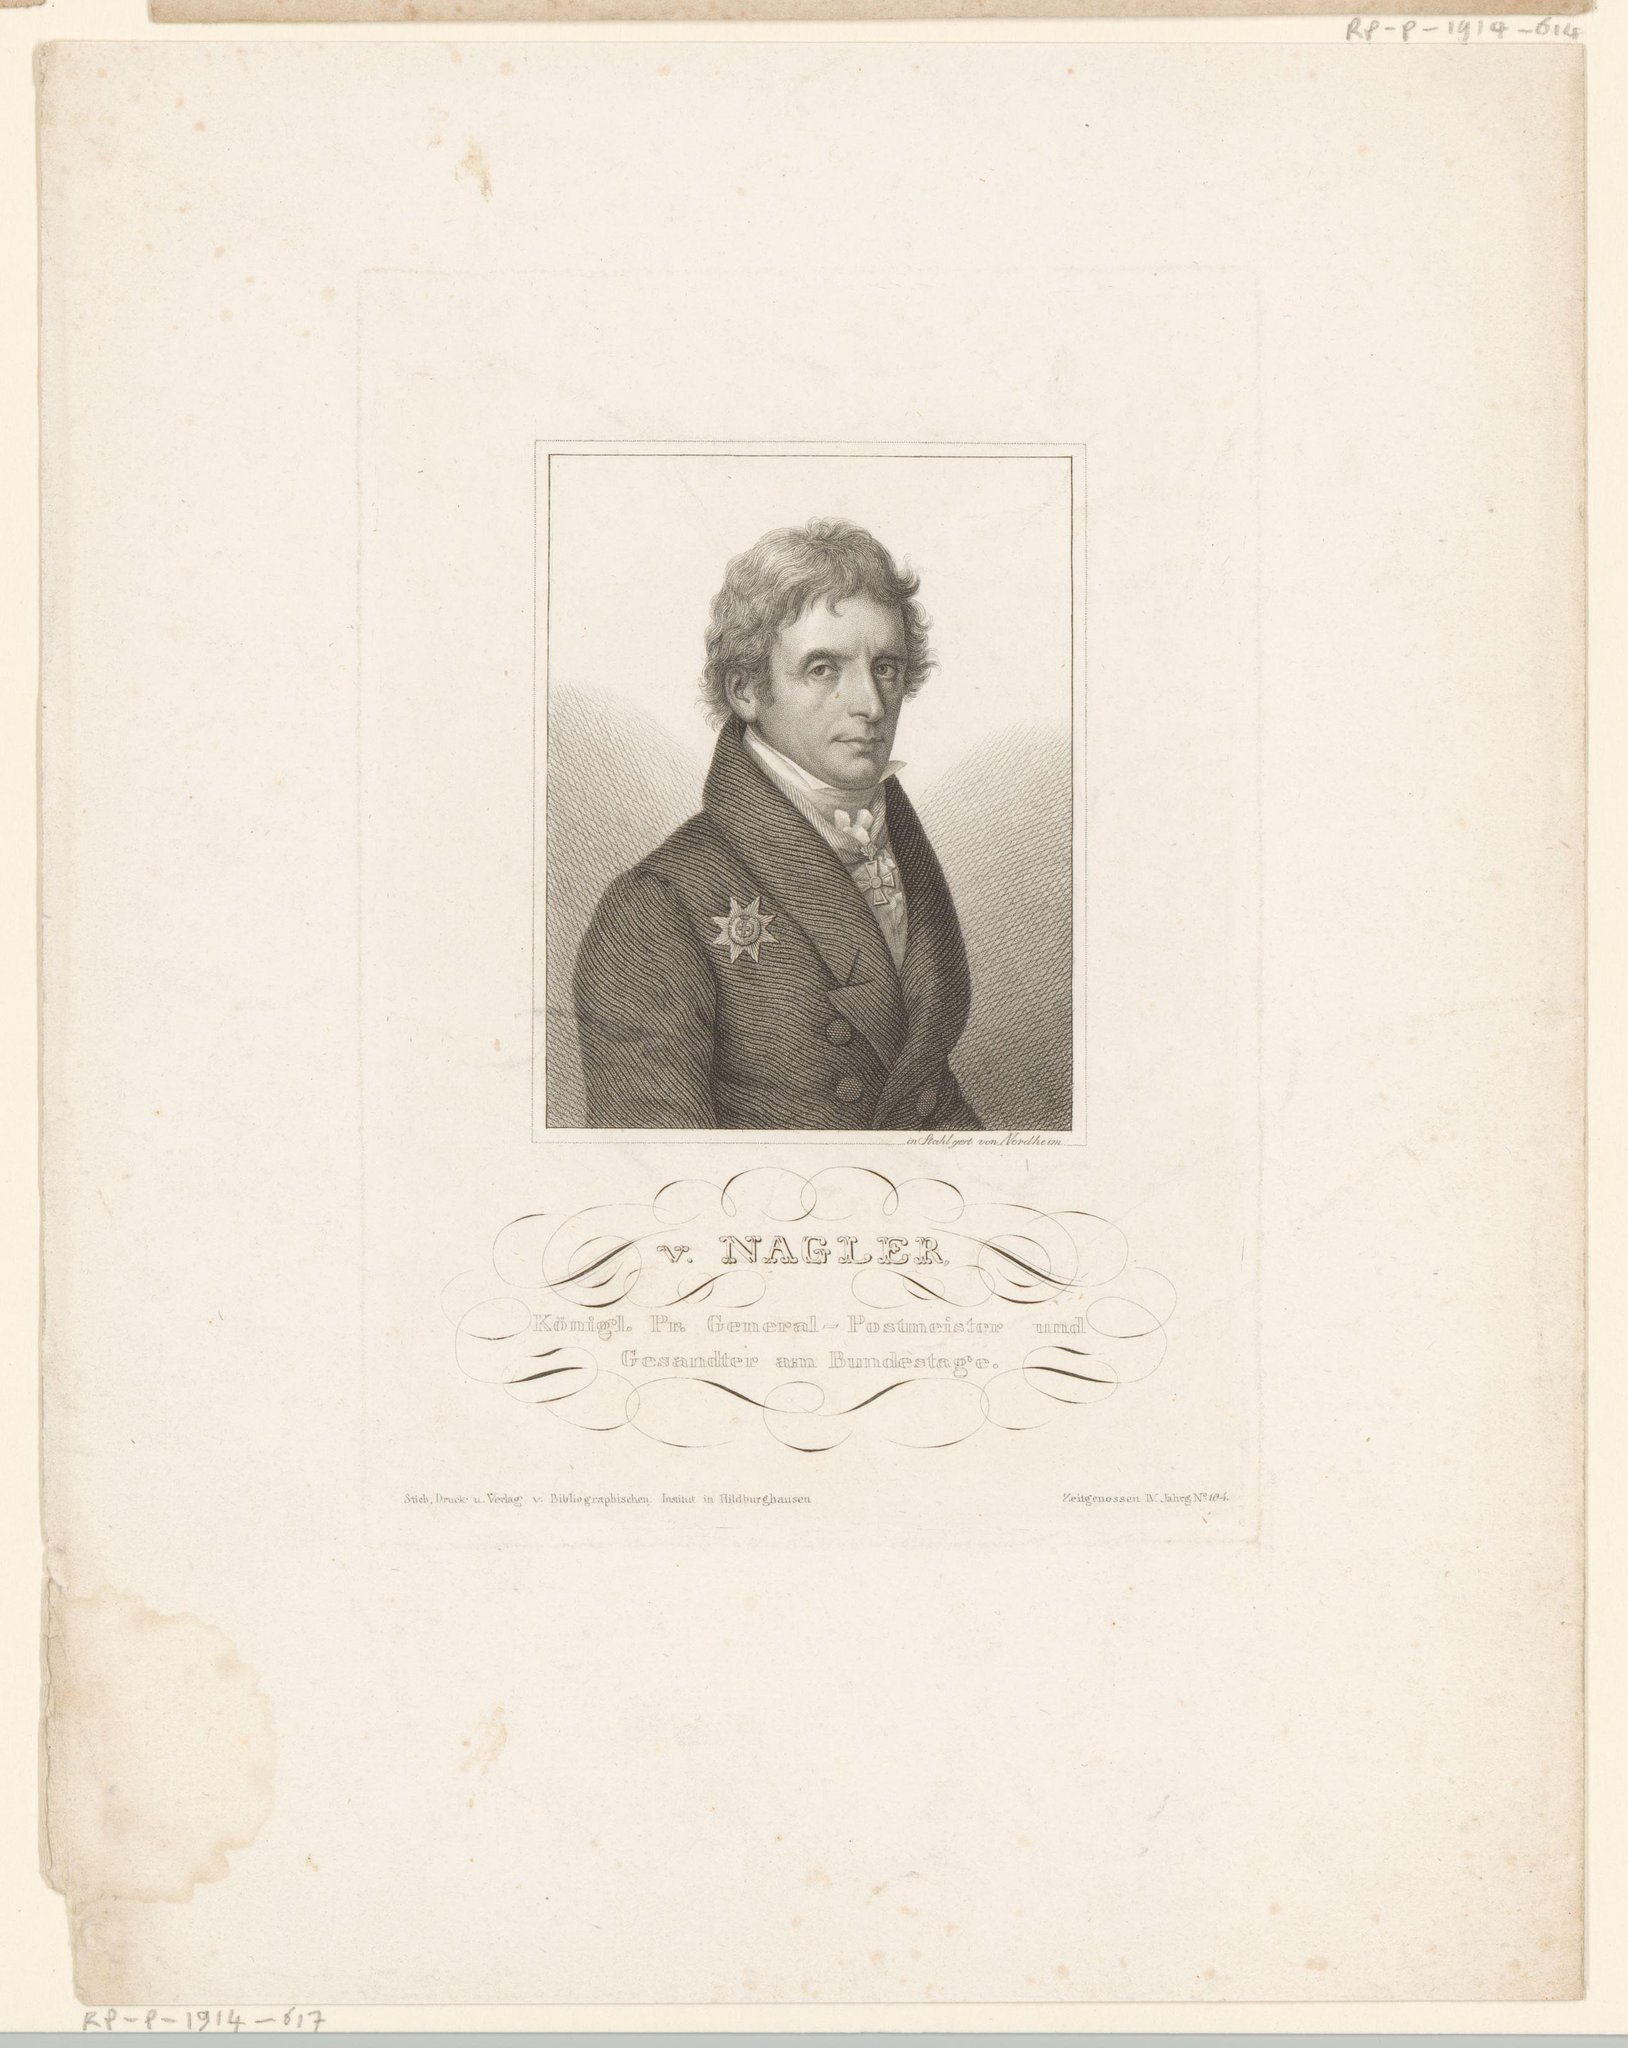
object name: print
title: Zeitgenossen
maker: johann georg nordheim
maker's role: print maker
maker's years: 1804-1853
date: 1829-1840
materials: paper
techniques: engraving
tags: berlin, historical persons, medals and other marks of military honour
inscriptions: collector's mark: Lugt 2228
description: Afkomstig uit de portretserie 'Zeitgenossen', uitgegeven tussen 1829 en circa 1840.